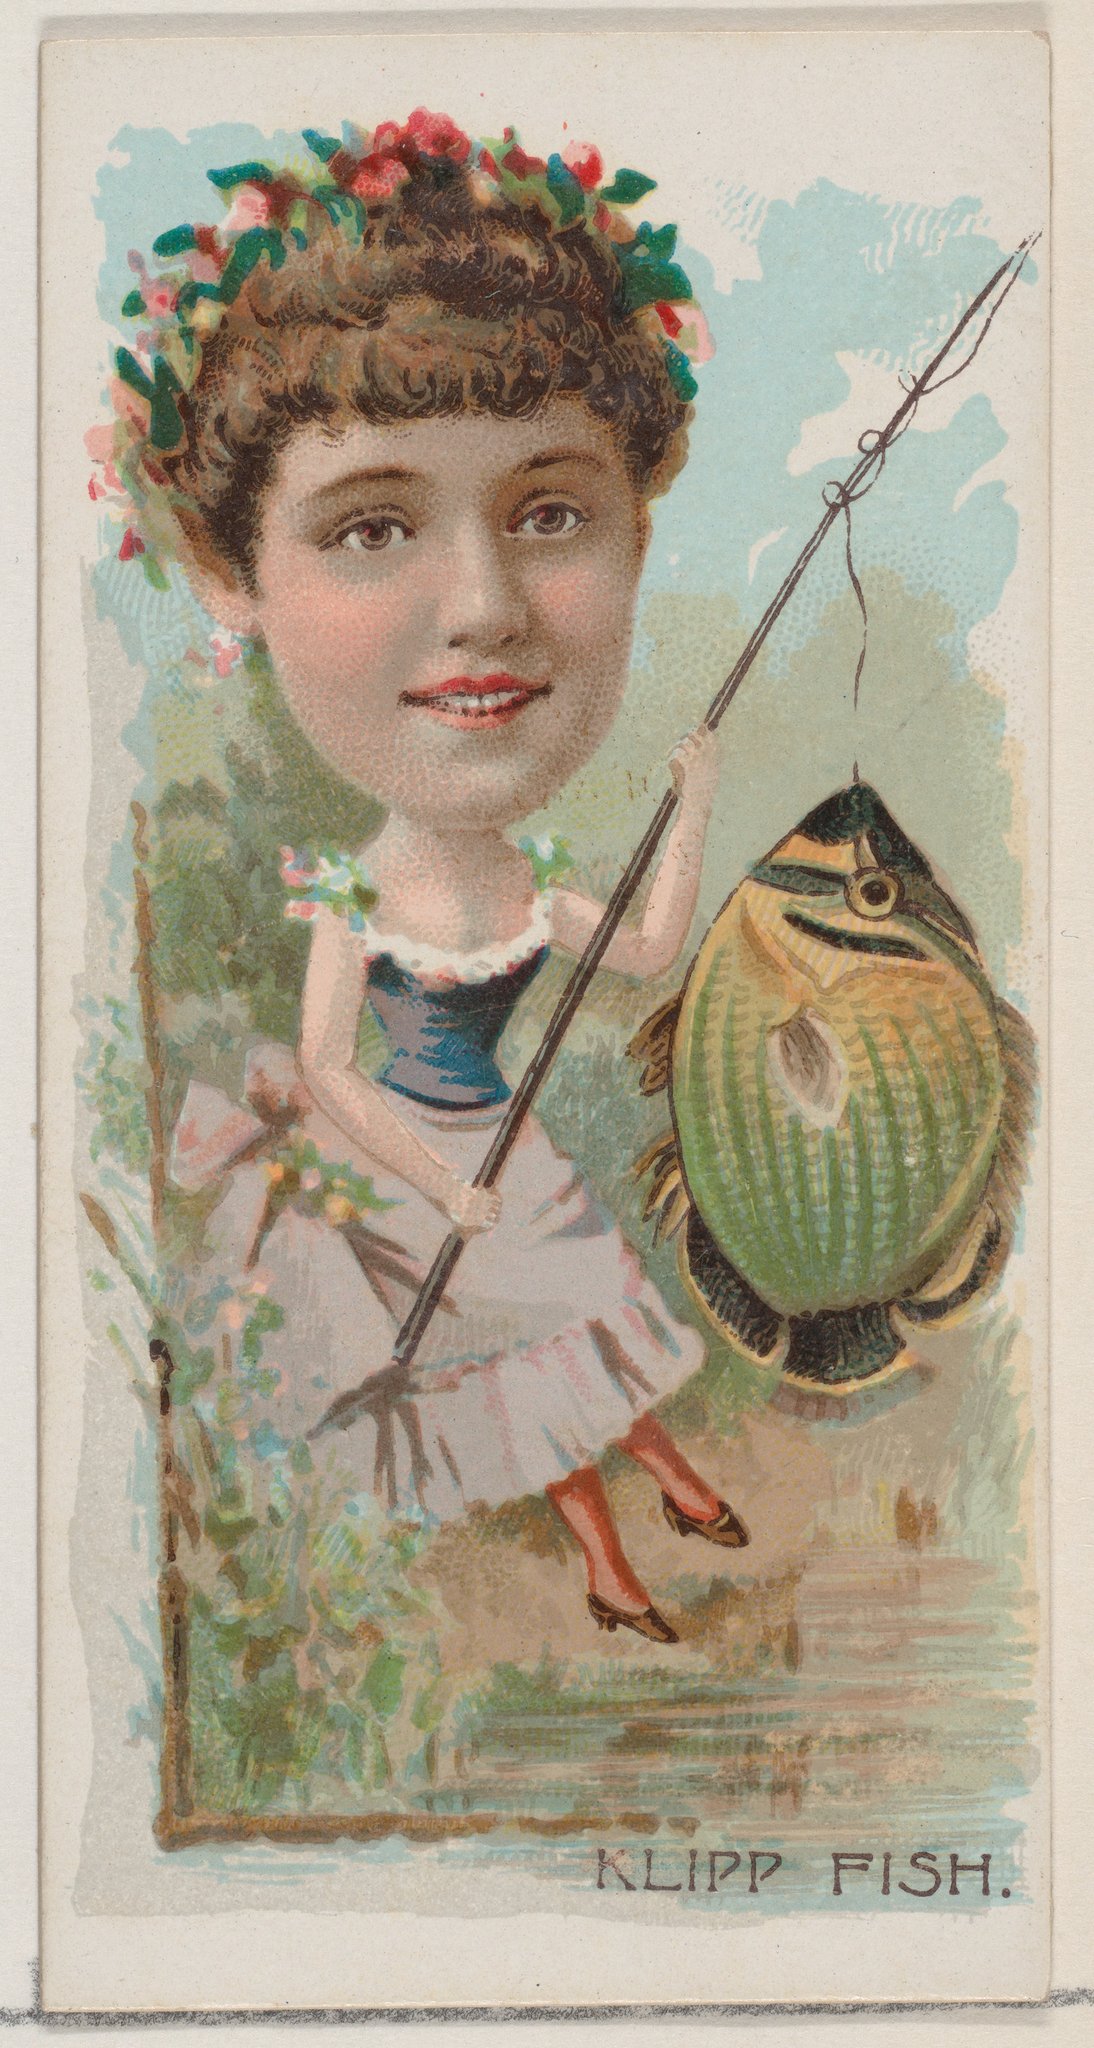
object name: print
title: Klipp Fish, from the series Fishers and Fish (N74) for Duke brand cigarettes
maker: knapp & company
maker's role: lithographer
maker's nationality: american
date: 1888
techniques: color lithograph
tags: women,fishing,fish